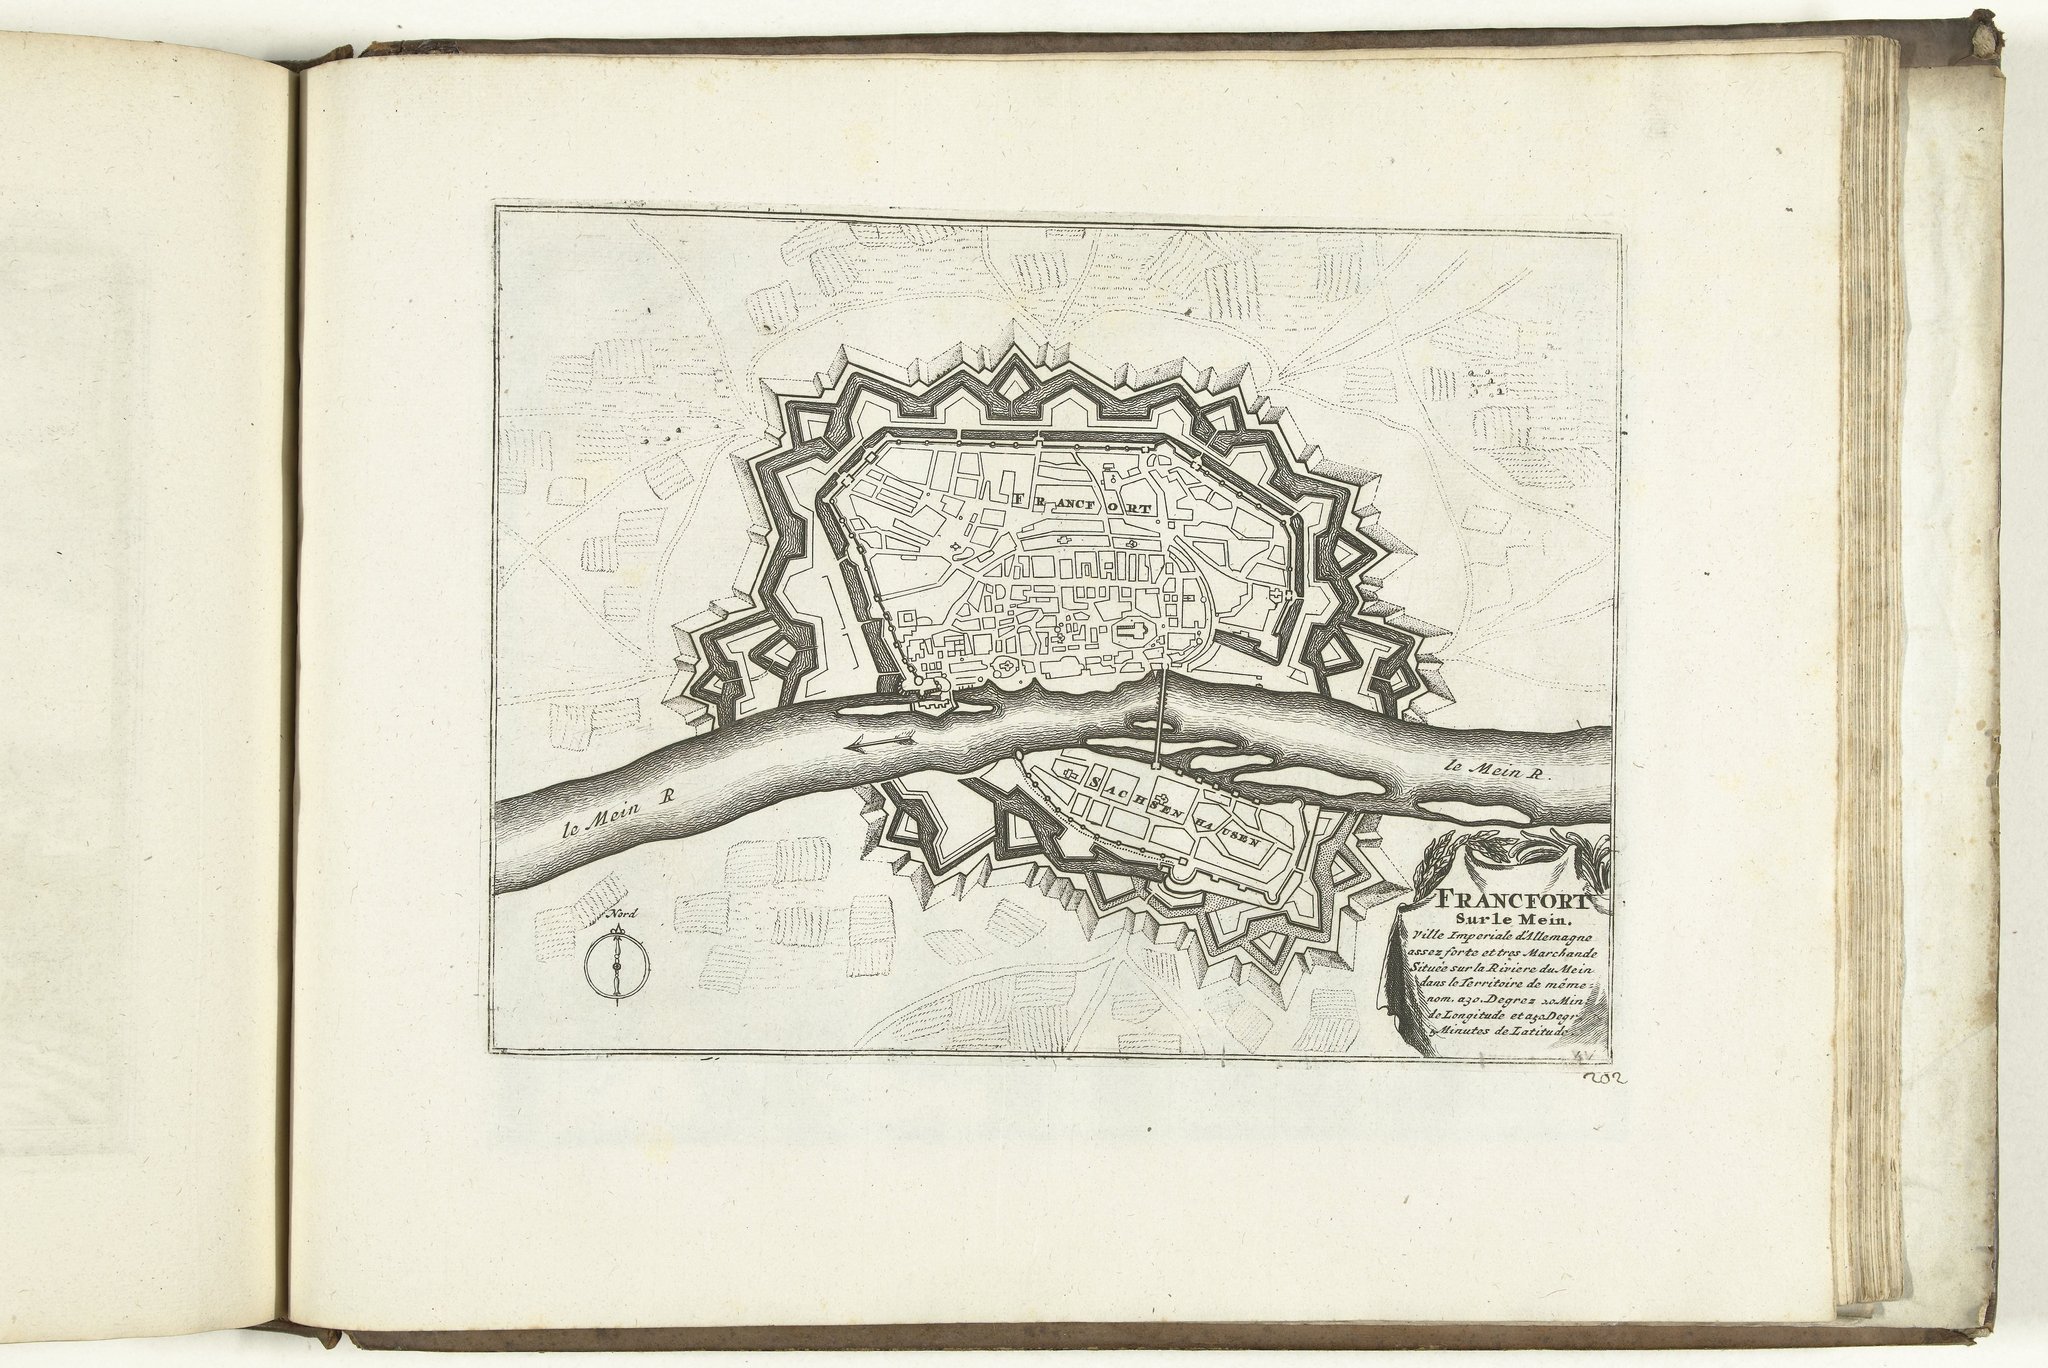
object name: print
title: Plattegrond van Frankfurt am Main, 1726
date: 1726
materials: paper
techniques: etching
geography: northern netherlands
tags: fortress, maps of cities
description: Plattegrond van de versterkingen om de plaats Frankfurt am Main. Plaat nr. 202 in deel IX van het prentwerk: Les Forces de l'Europe, Asie, Afrique et Amerique ... Comme aussi les Cartes des Côtes de France et d'Espagne uit 1726, dit eerste deel met 238 met de hand genummerde platen van vermaarde sterke steden en vestingen in het kader van de Spaanse Successieoorlog 1701-1713. Voor het merendeel zijn deze platen gekopieerd naar de anonieme Franse platen van vermaarde sterke steden en vestingen: in Les forces de l'Europe en in: Le theatre de la guerre, dans les Pays-Bas, beide oorspronkelijk uitgegeven door Nicolas de Fer te Parijs (1693-1697) in het kader van de Negenjarige Oorlog. Titel en opschriften in het Frans.